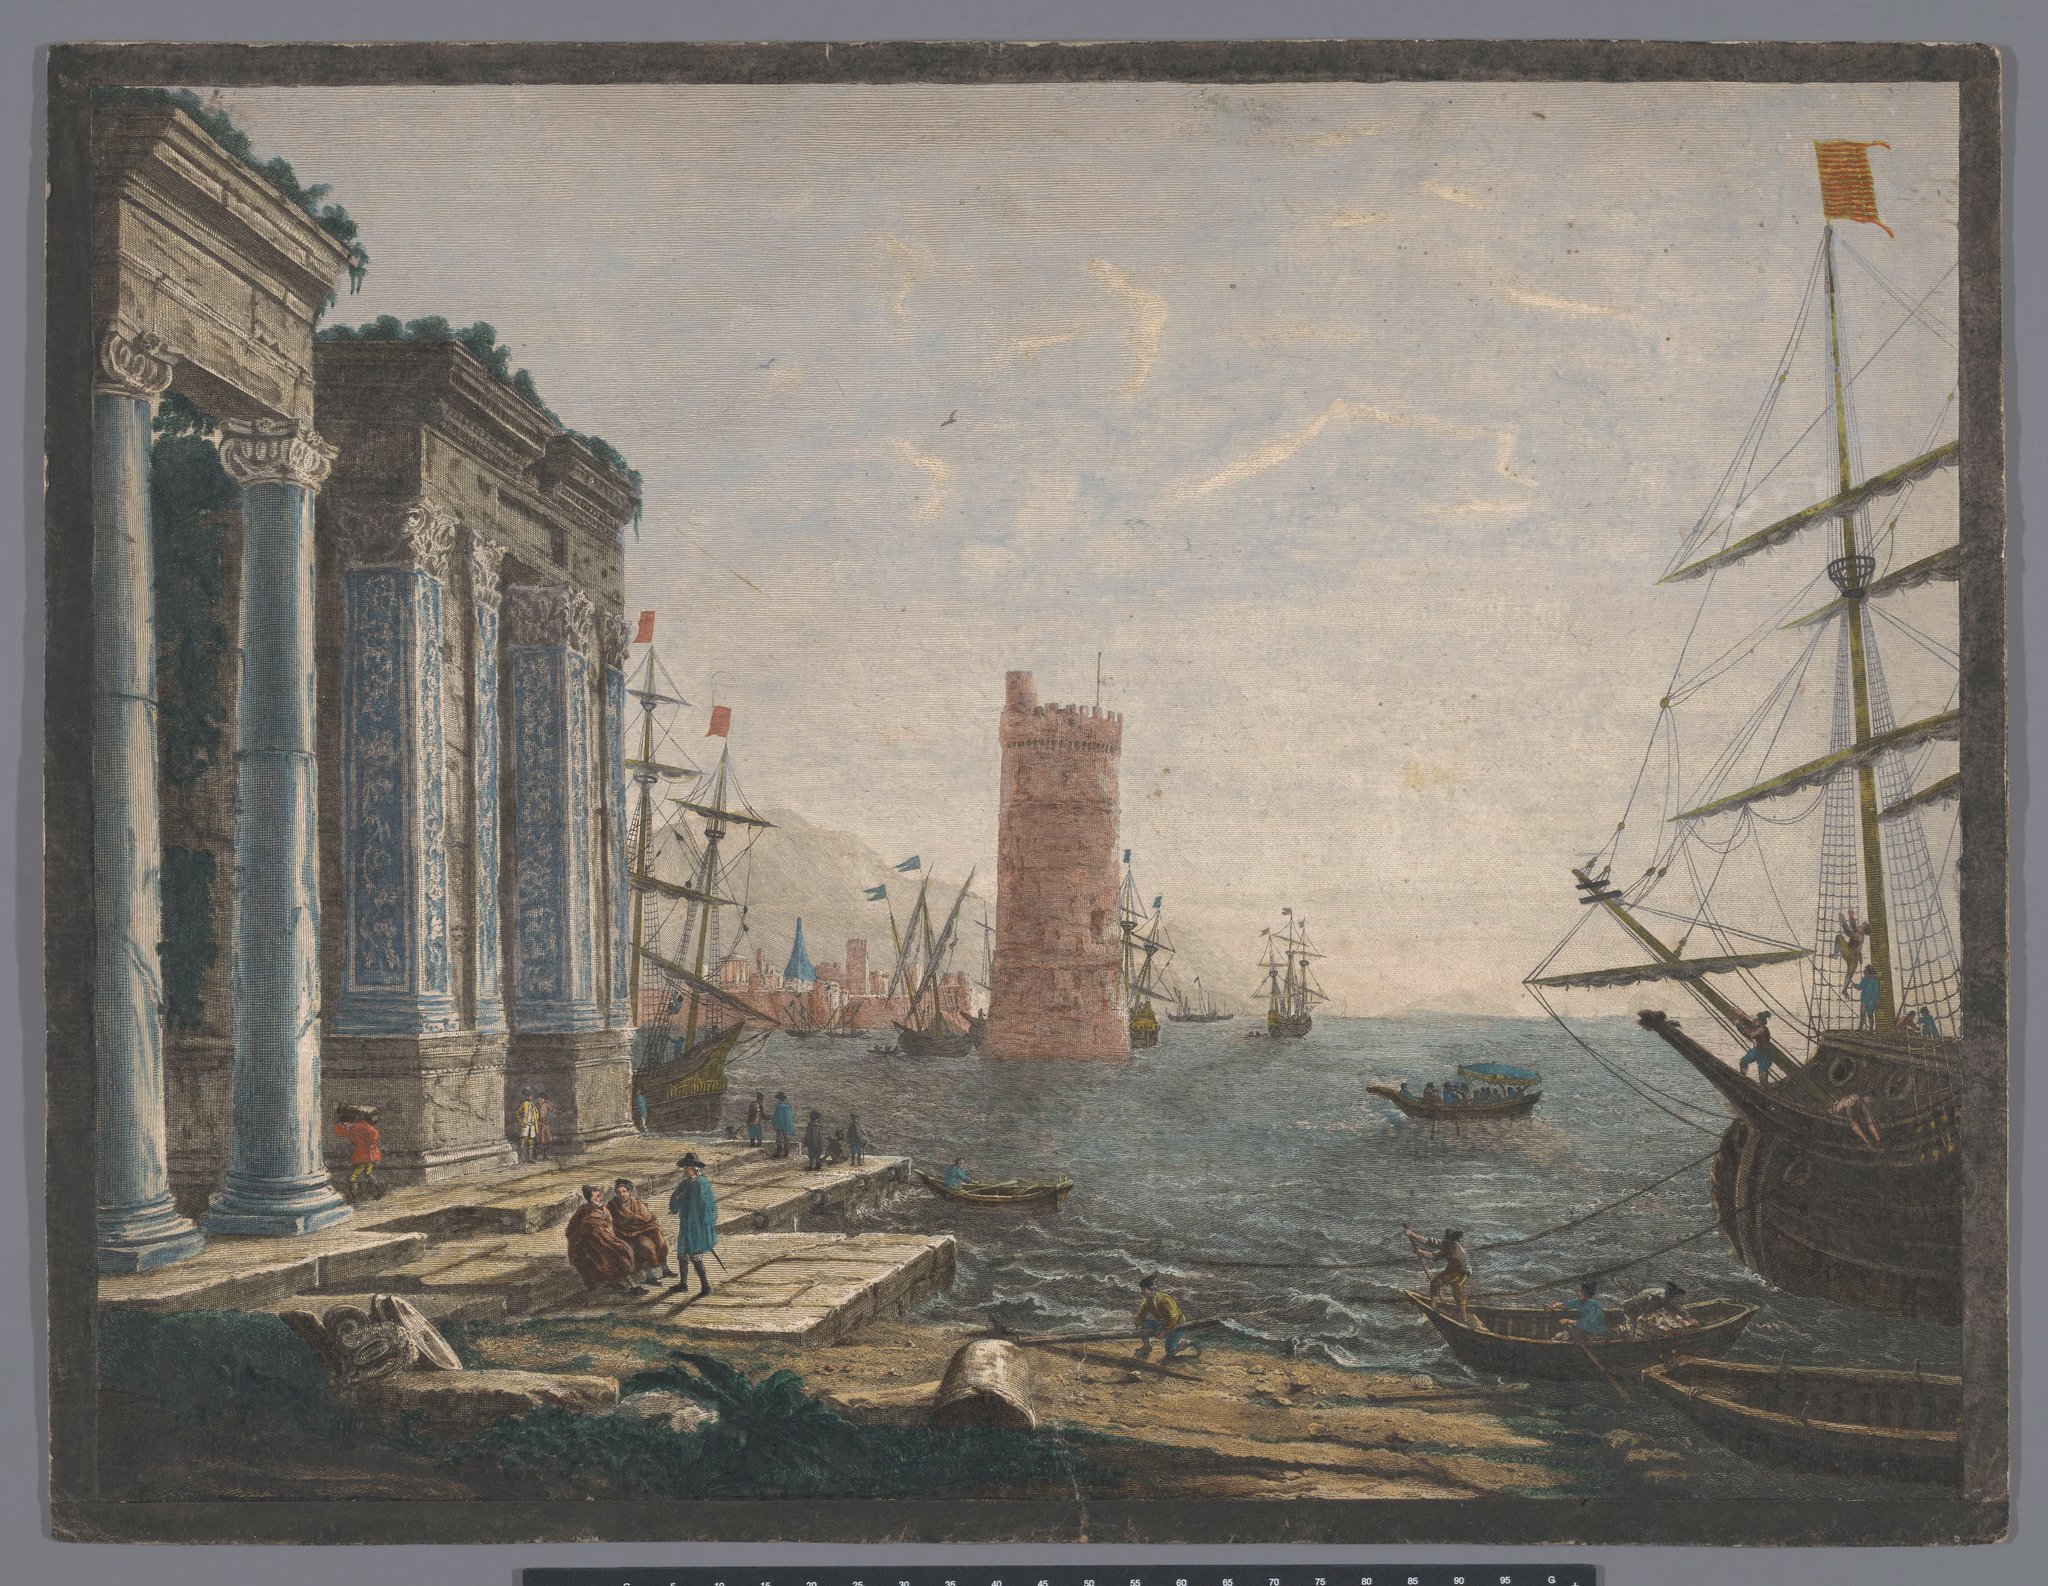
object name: print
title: Gezicht op een haven met schepen en boten op het water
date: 1752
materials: cardboard, paper, watercolor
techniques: brush, etching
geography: london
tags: harbour, sailing-ship, sailing-boat, rowing-boat, canoe, etc., sea (seascape) (+ landscape with figures, staffage), civic architecture; edifices; dwellings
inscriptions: collector's mark: Lugt 2233